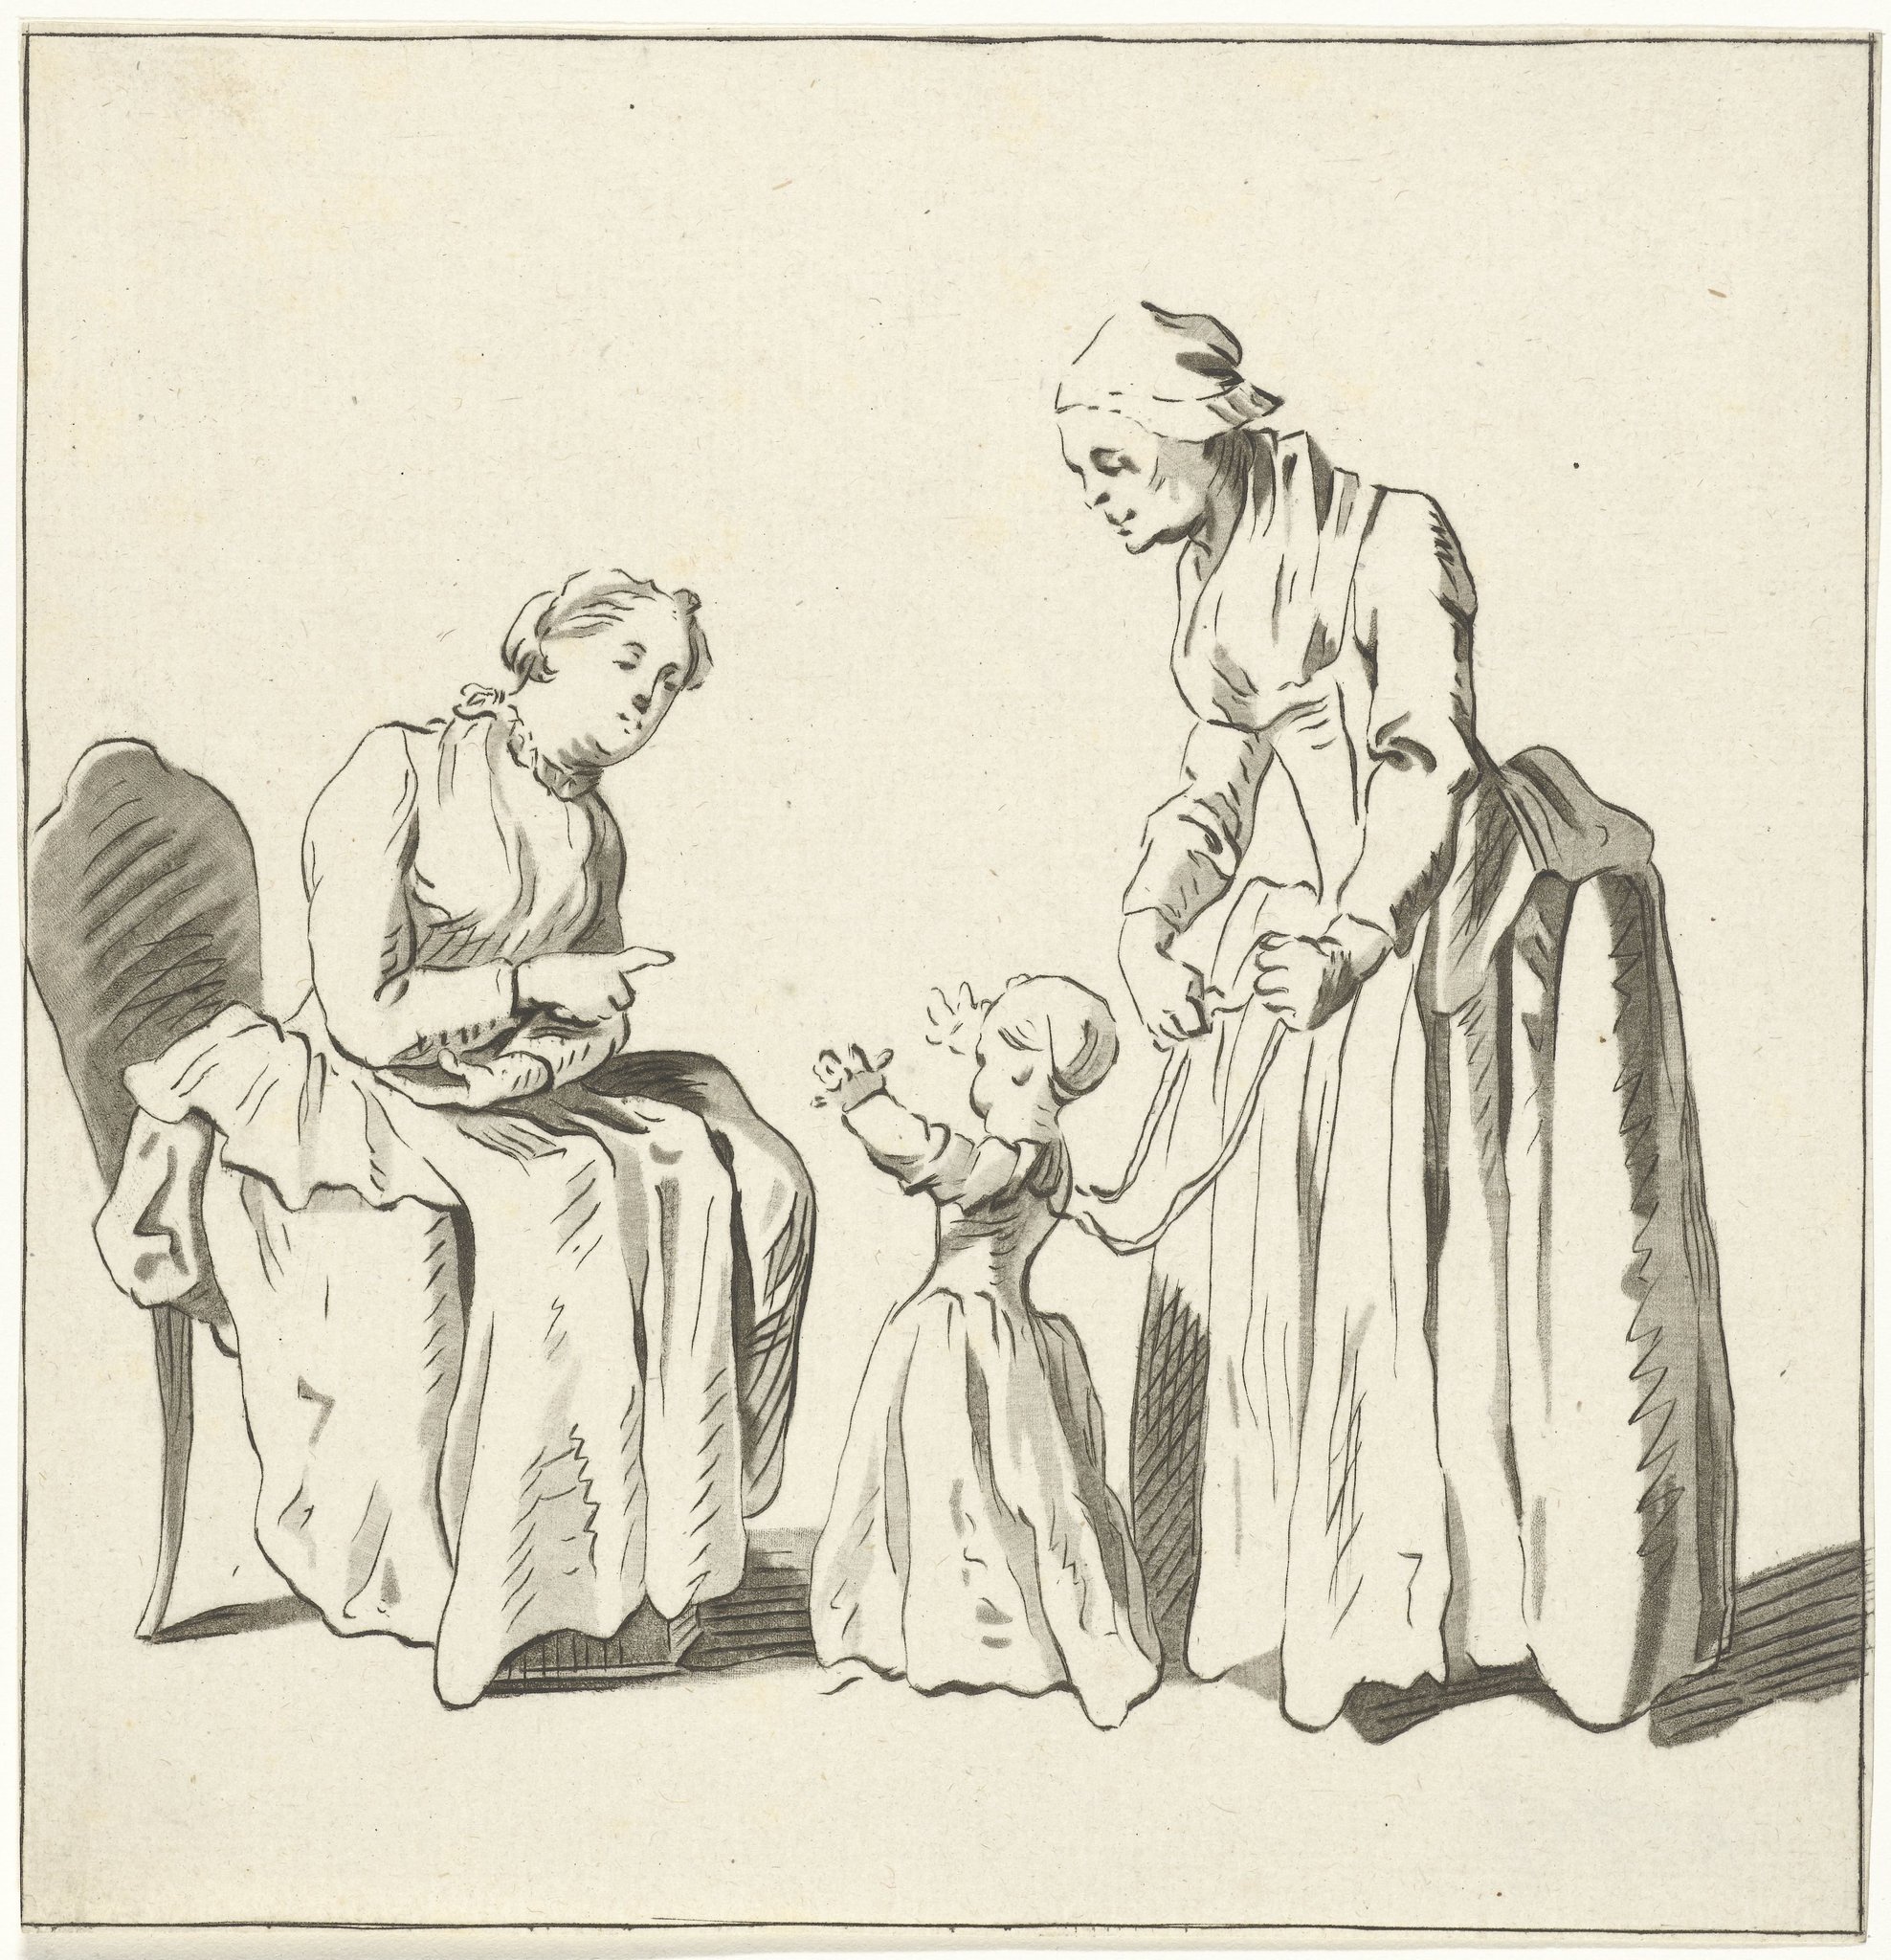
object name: print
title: Lopend kind bij twee vrouwen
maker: benjamin martini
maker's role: print maker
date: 1777-1780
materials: paper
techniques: aquatint, etching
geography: amsterdam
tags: learning to walk, the first steps - aa - girl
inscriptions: collector's mark: Lugt 2228